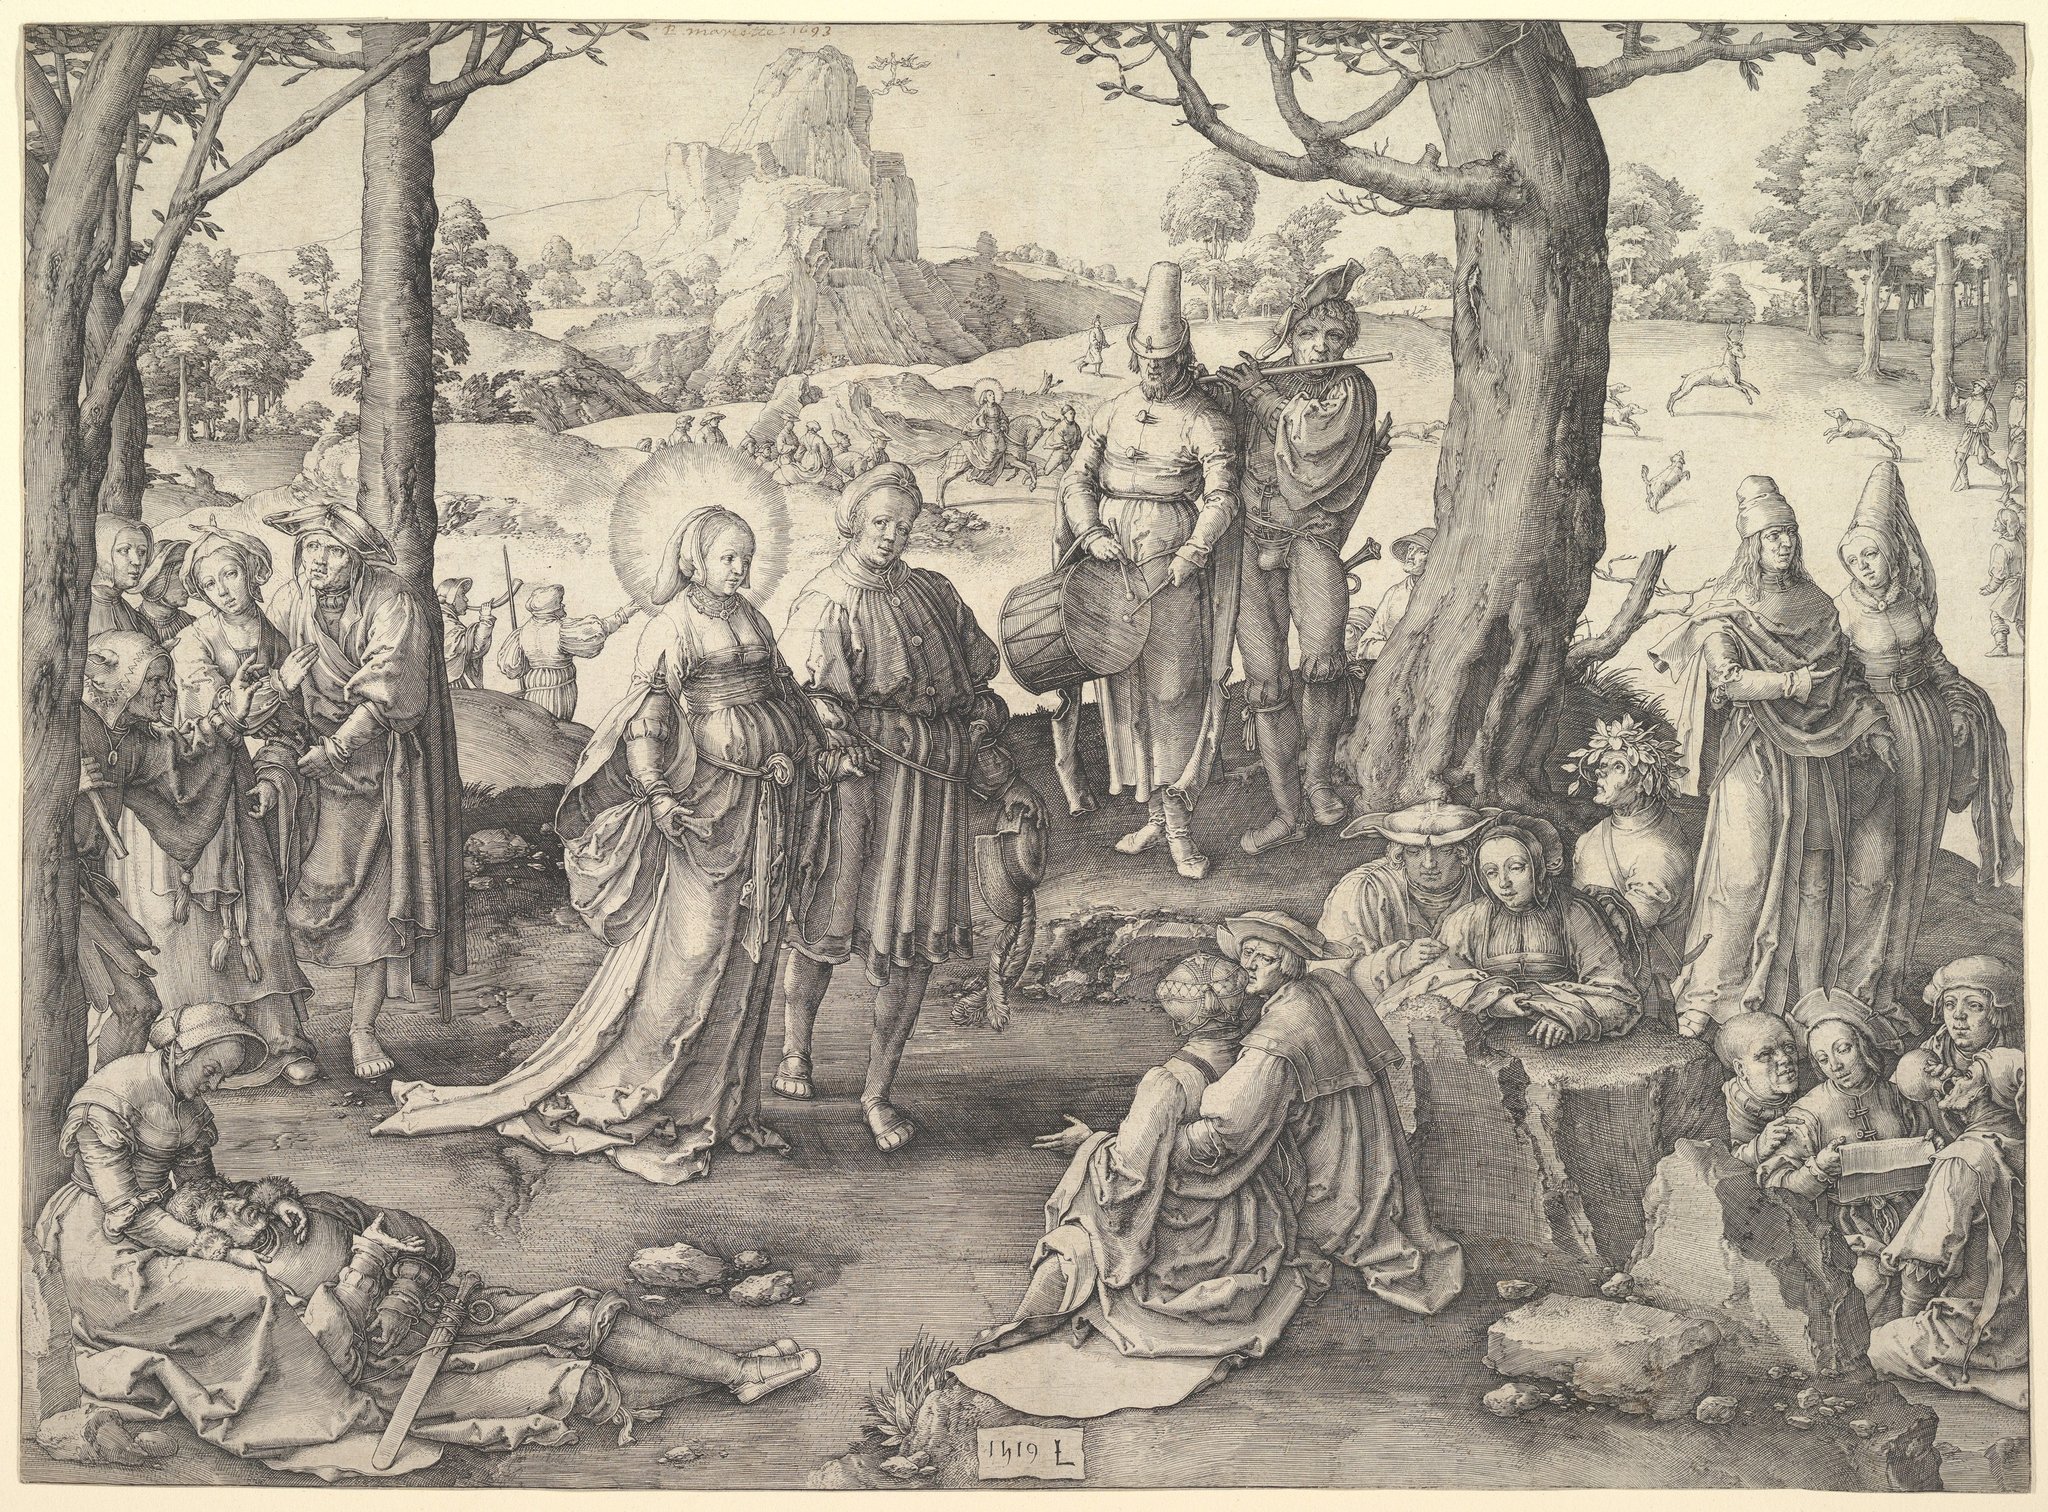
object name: print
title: Dance of St. Mary Magdalene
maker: lucas van leyden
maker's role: artist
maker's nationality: netherlandish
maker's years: 1494-1533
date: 1519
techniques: engraving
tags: men,women,dancing,trees,mary magdalene